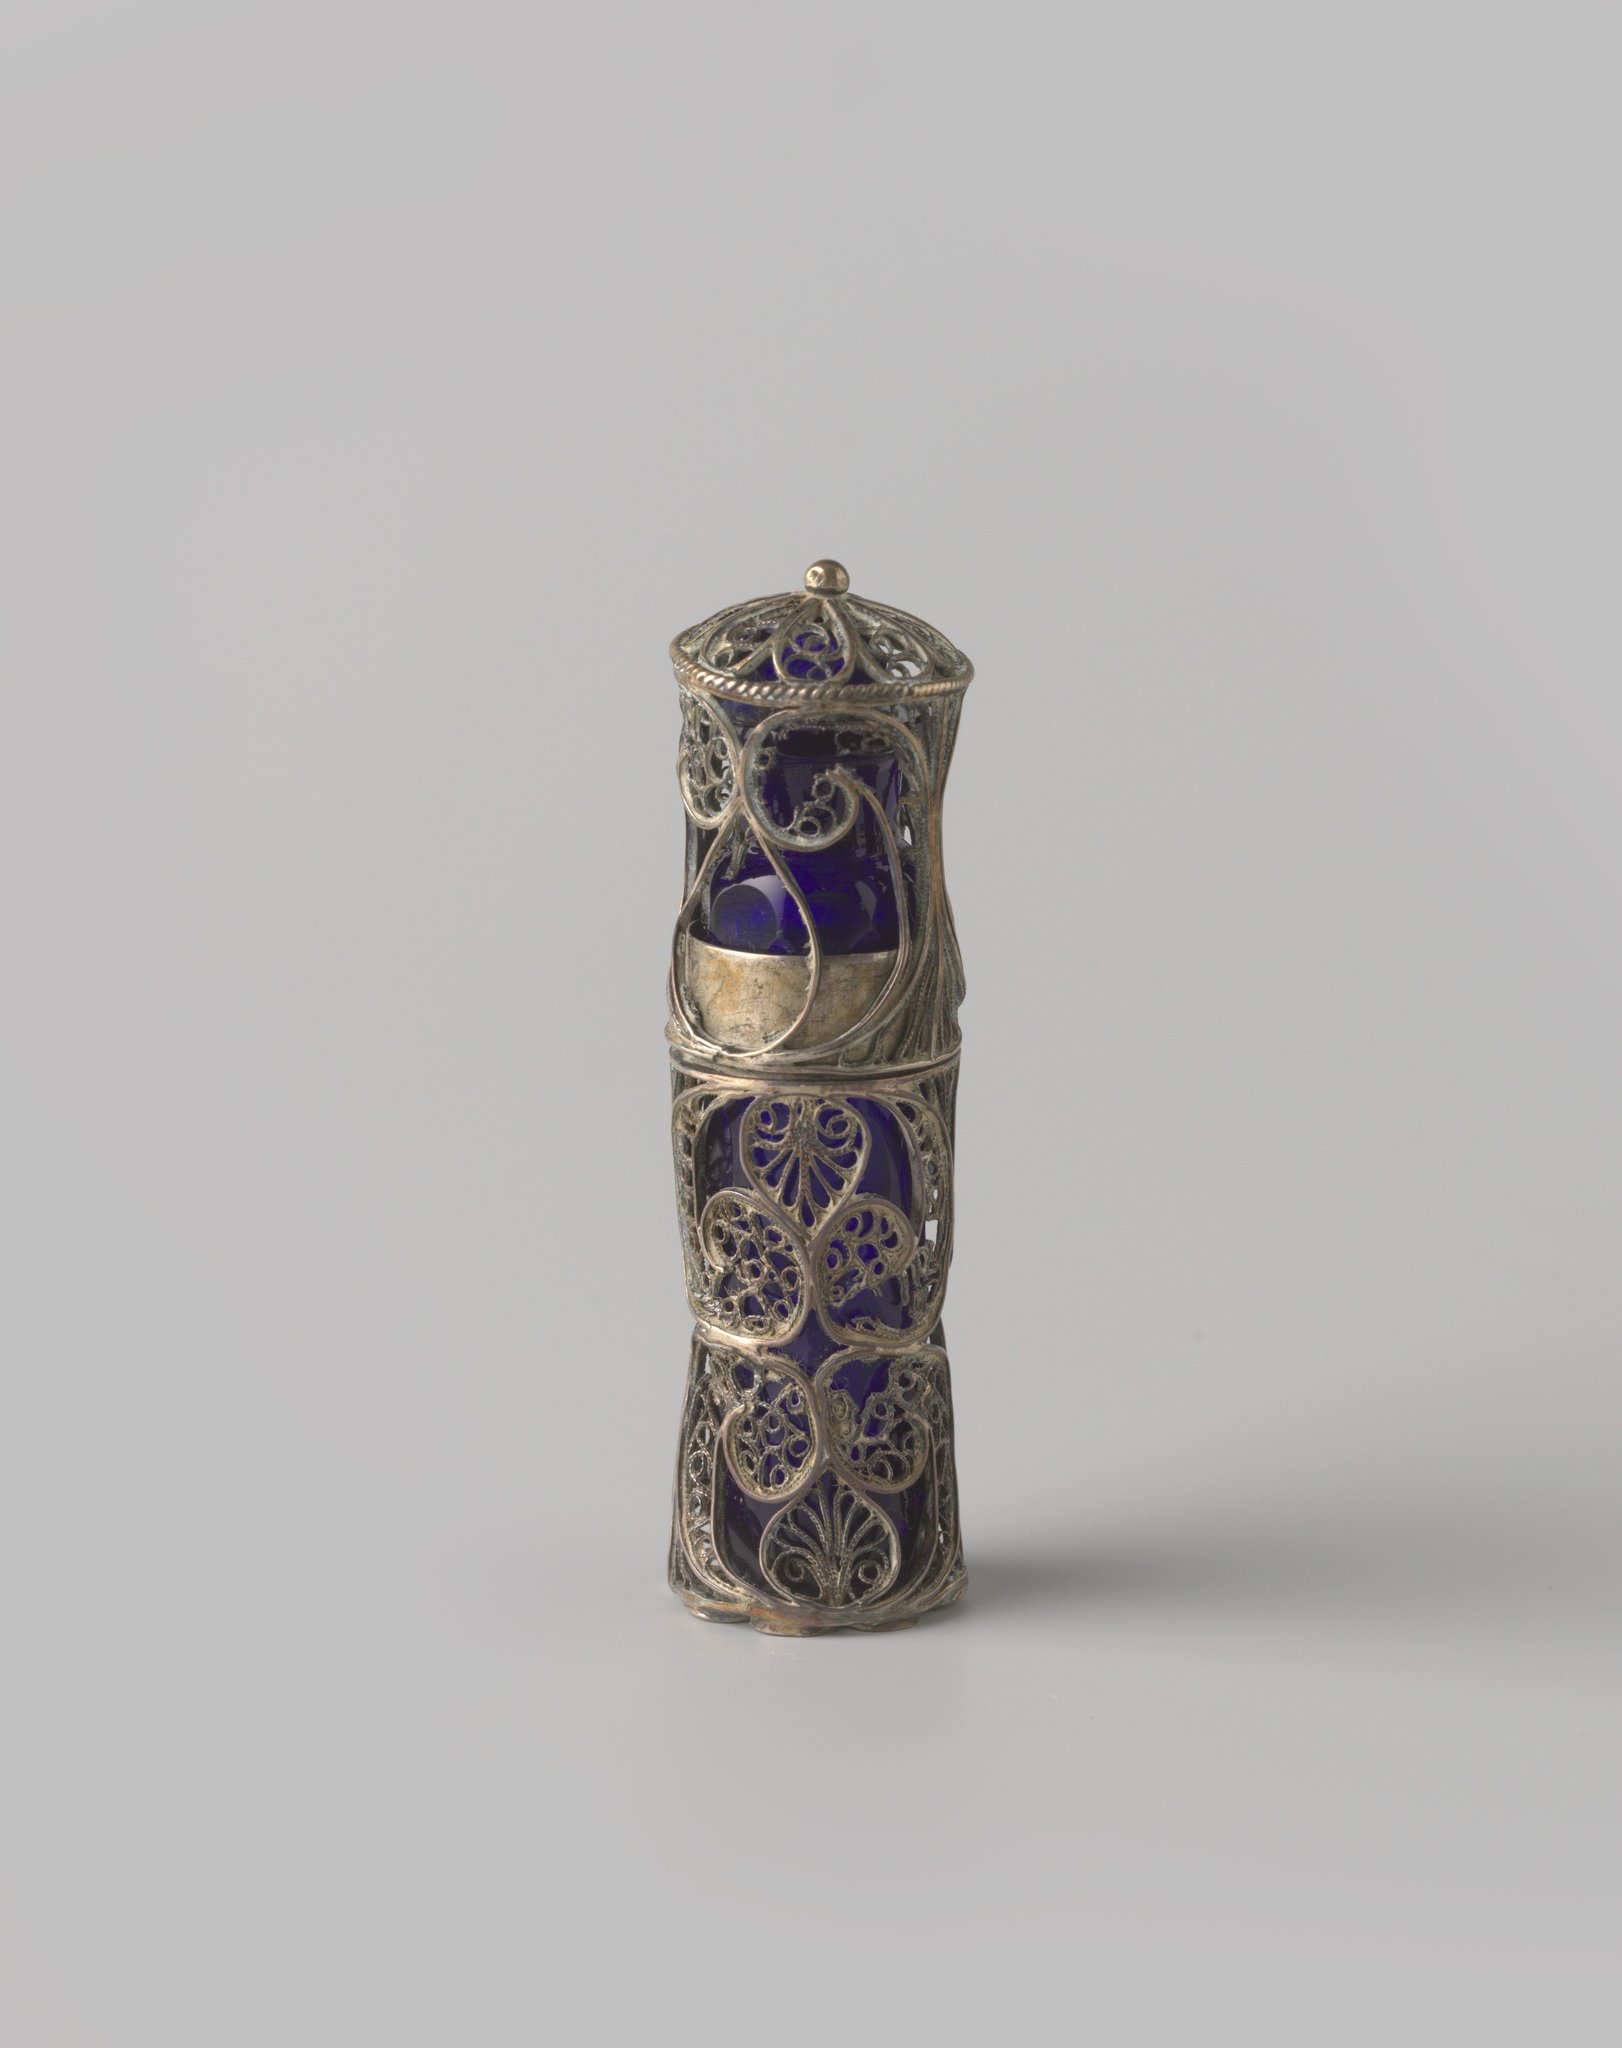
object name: flacon, flakon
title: Flacon van blauw glas met zilverfiligrein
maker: Anonymous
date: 1400-1950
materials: glass, silver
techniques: filigree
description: Flacon van blauw glas met zilverfiligrein.